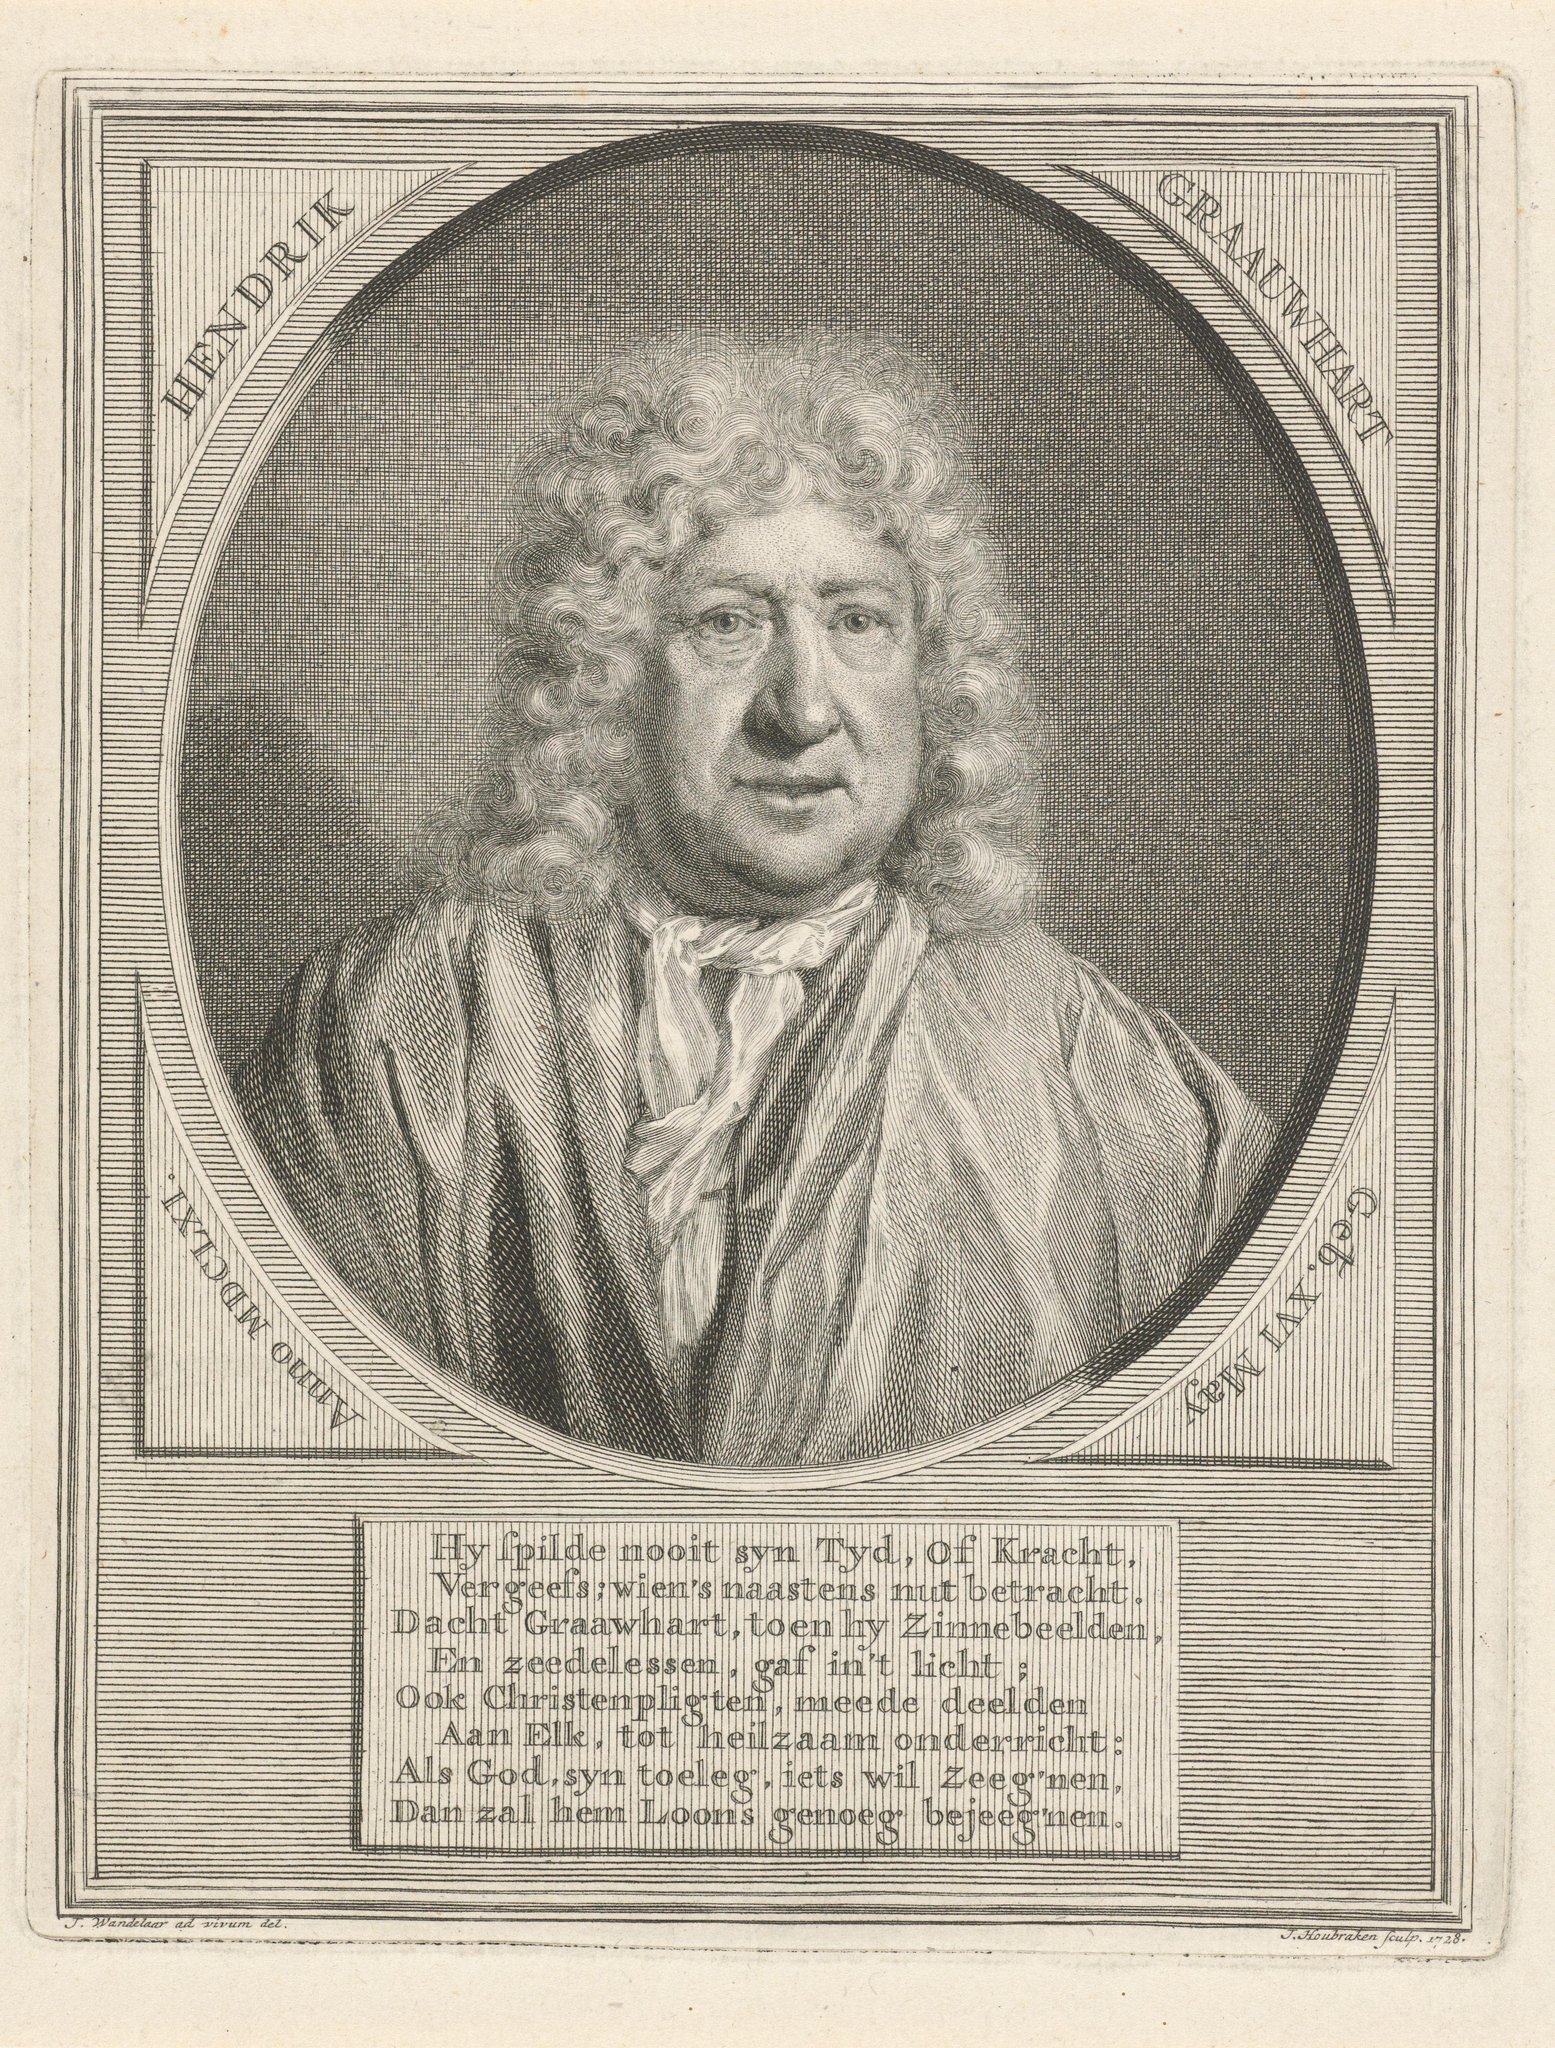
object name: print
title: Hendrik Graauwhart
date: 1728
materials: paper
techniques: engraving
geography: amsterdam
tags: hendrik graauwhart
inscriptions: collector's mark: Lugt 240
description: Buste van Hendrik Graauwhart op 67-jarige leeftijd in een ovaal. Om het ovaal vier hoeken met daarin in delen zijn naam en geboortegegevens. Onder het portret een achtregelig vers in het Nederlands.